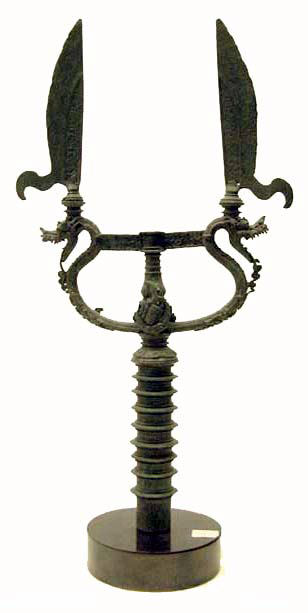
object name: halberd head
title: Halberd Head with Two Nagas Supporting Blades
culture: indonesian, javanese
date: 1251-1300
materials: copper alloy